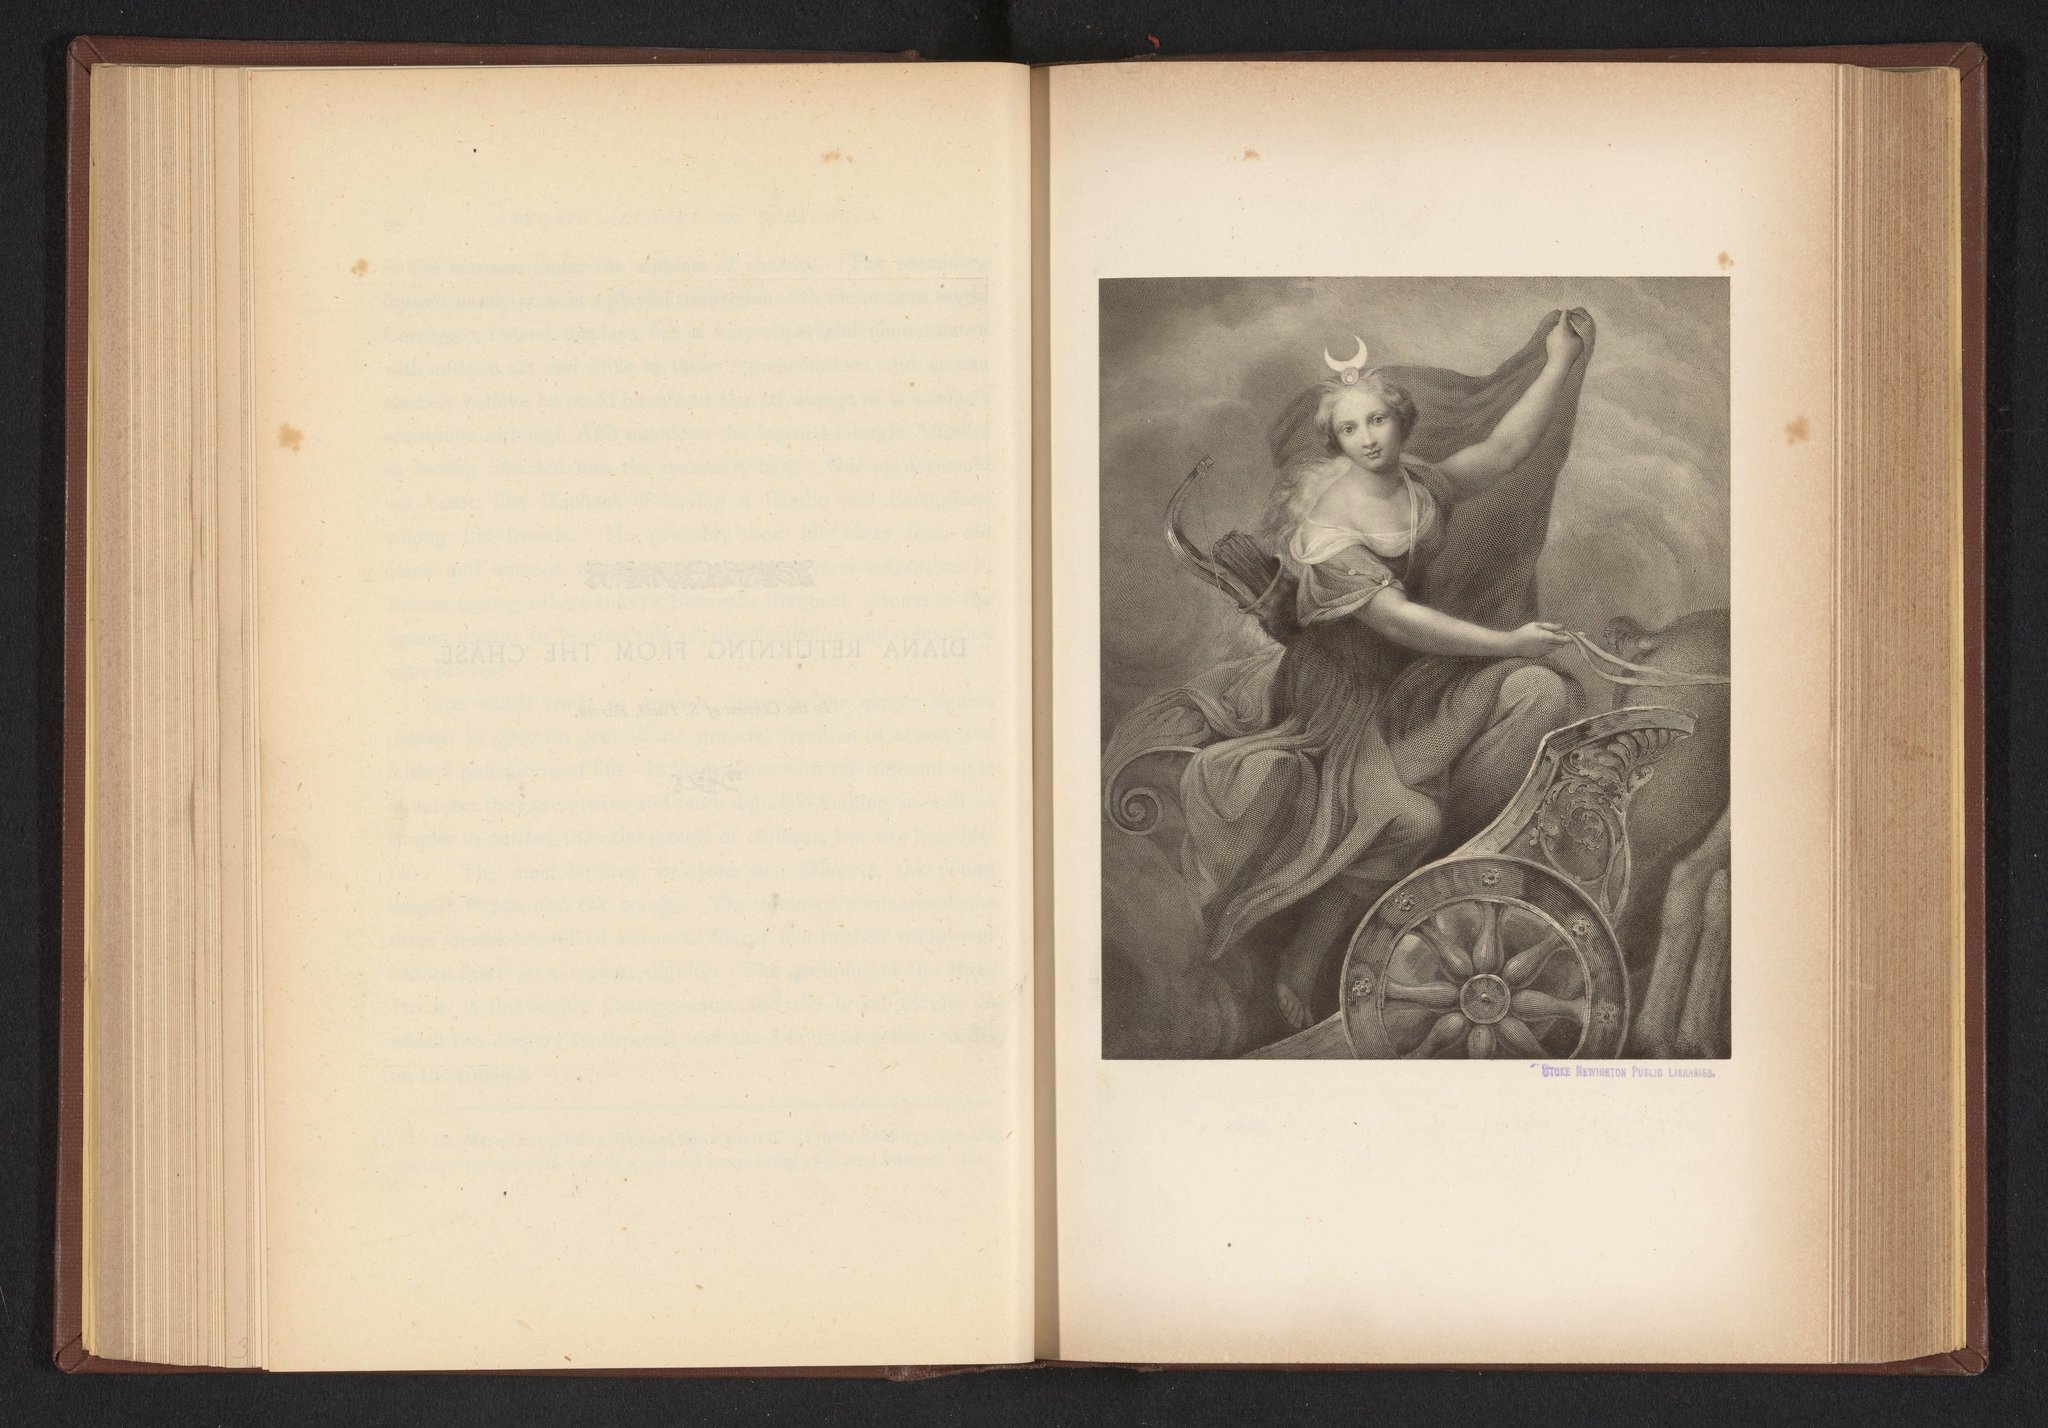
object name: page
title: Fotoreproductie van een prent naar een schilderij, voorstellende Diana keert terug van de jacht in haar rijtuig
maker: Anonymous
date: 1870-1876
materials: paper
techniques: woodburytype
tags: (story of) diana (artemis), ancient forms of military vehicles: chariot, battle wagon, etc.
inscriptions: inscription: ‘Stoke Newington Public Libraries’